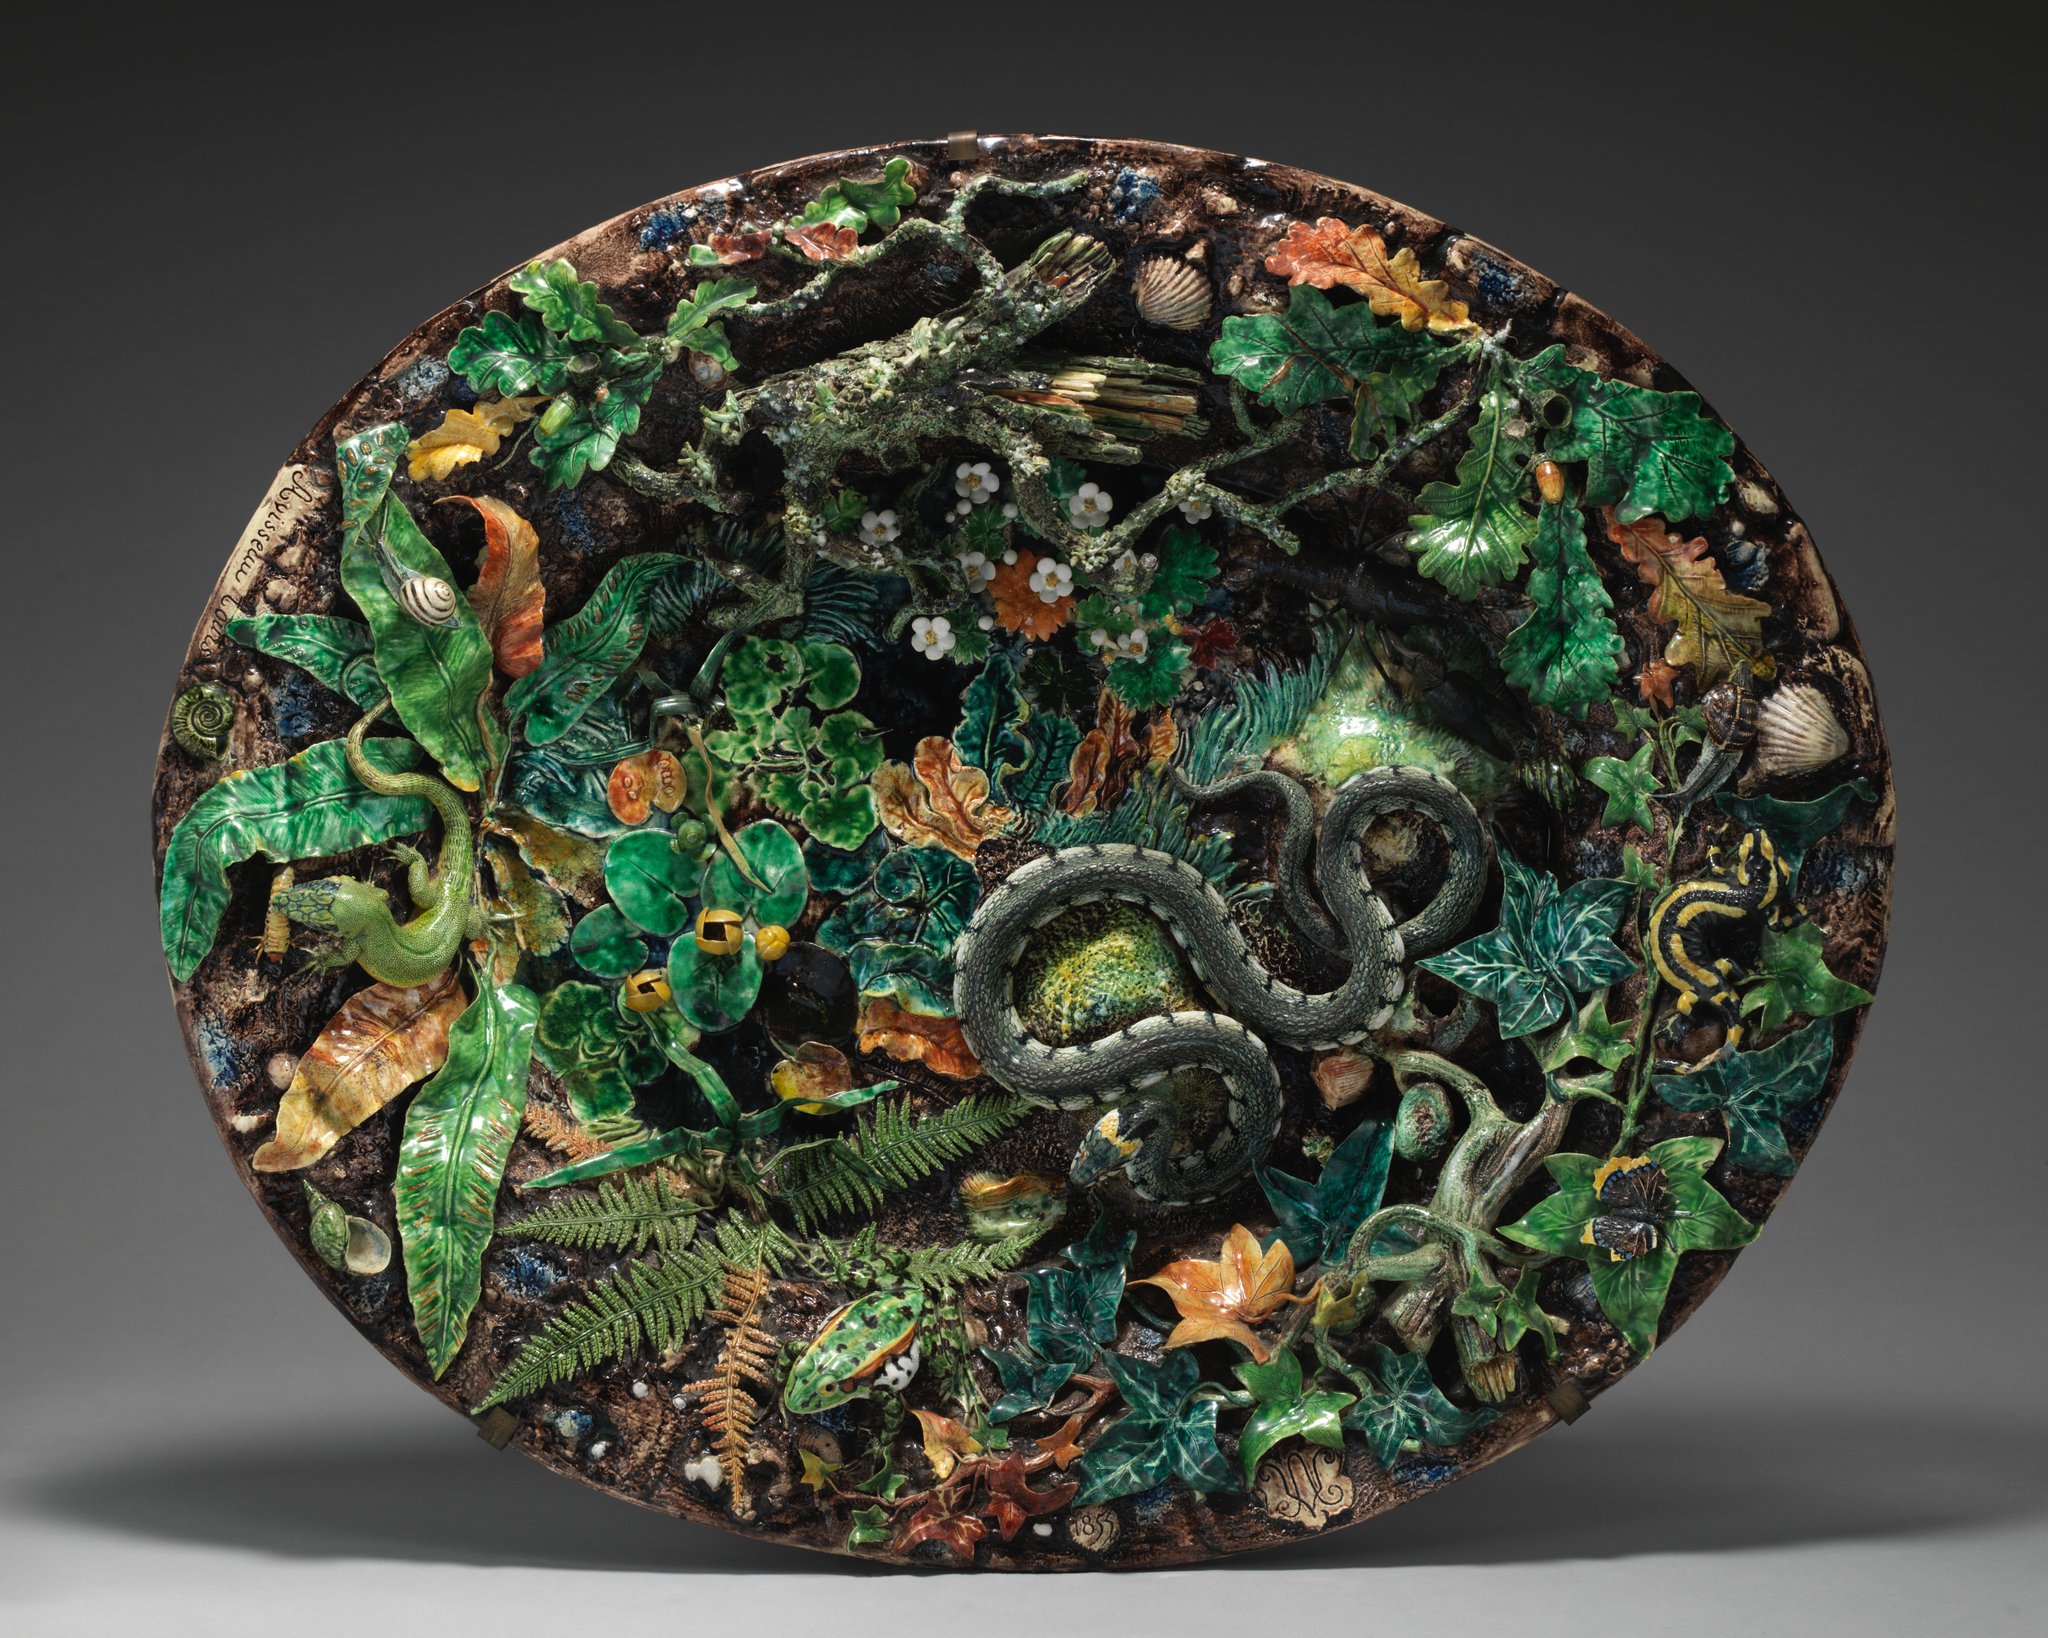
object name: platter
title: Large basin with snake, ferns, and bark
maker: charles-jean avisseau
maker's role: maker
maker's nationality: french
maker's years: 1796-1861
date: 1850-1855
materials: earthenware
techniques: glazing